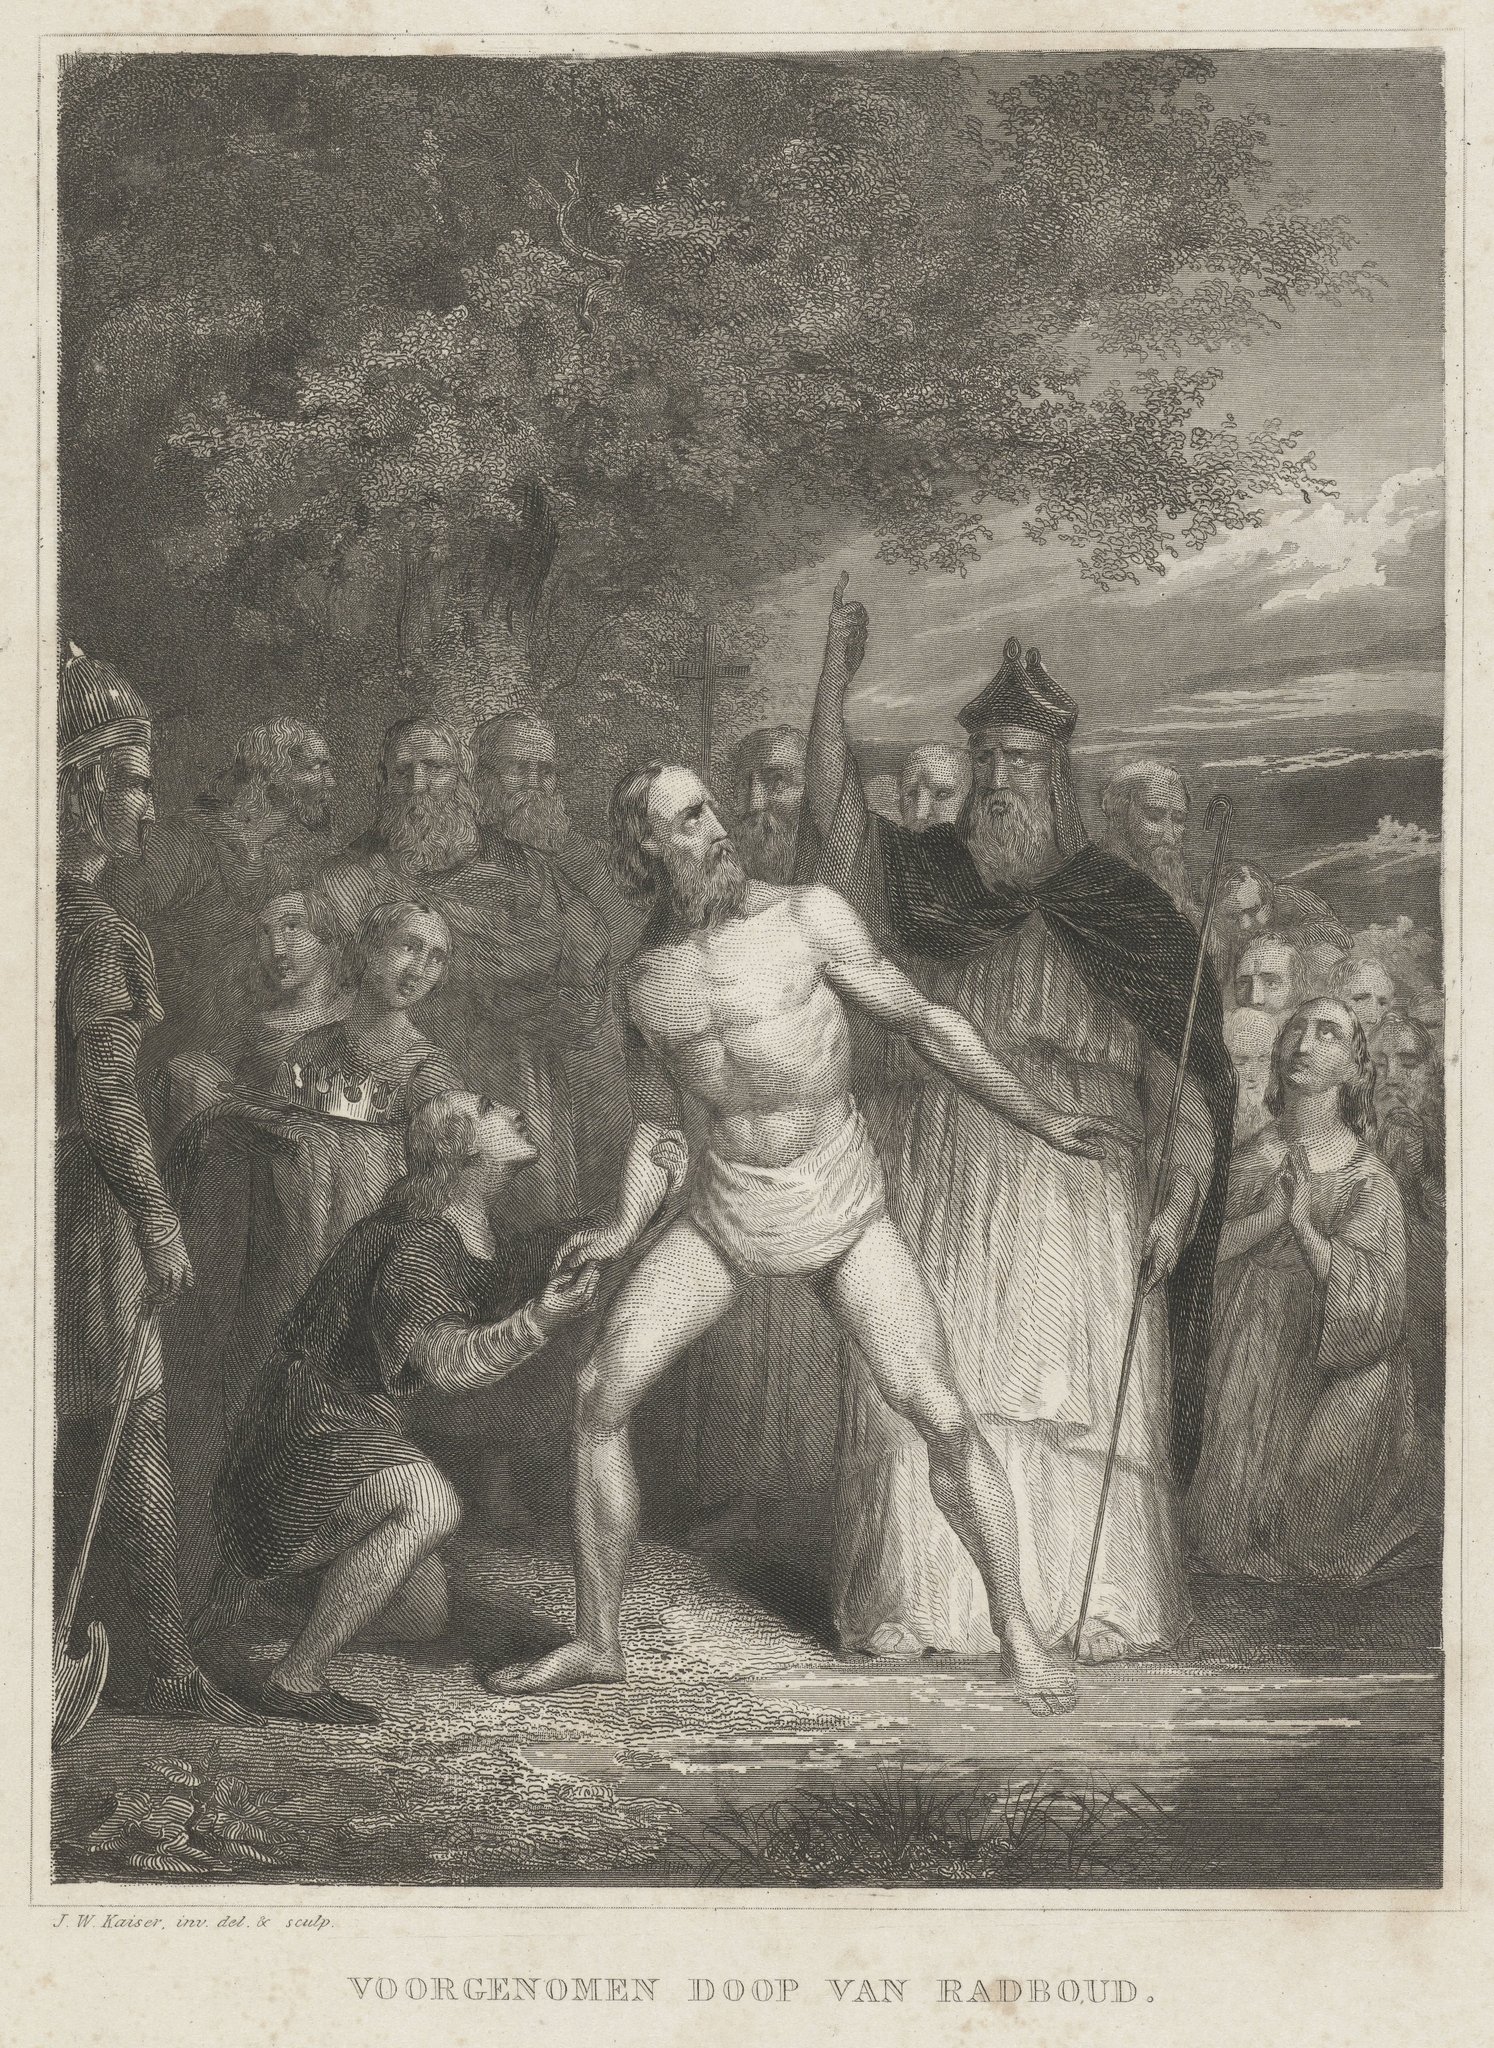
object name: print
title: Voorgenomen doop van Radboud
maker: johann wilhelm kaiser (i)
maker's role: draughtsman, print maker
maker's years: 1813-1900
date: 1838-1840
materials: paper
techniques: engraving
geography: netherlands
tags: solemn baptism (by bishop or priest), netherlands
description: Radbod, koning der Friezen, weigert zich in 719 door bisschop Wulfram van Sens te laten dopen. Radbod staat met één been in het water.